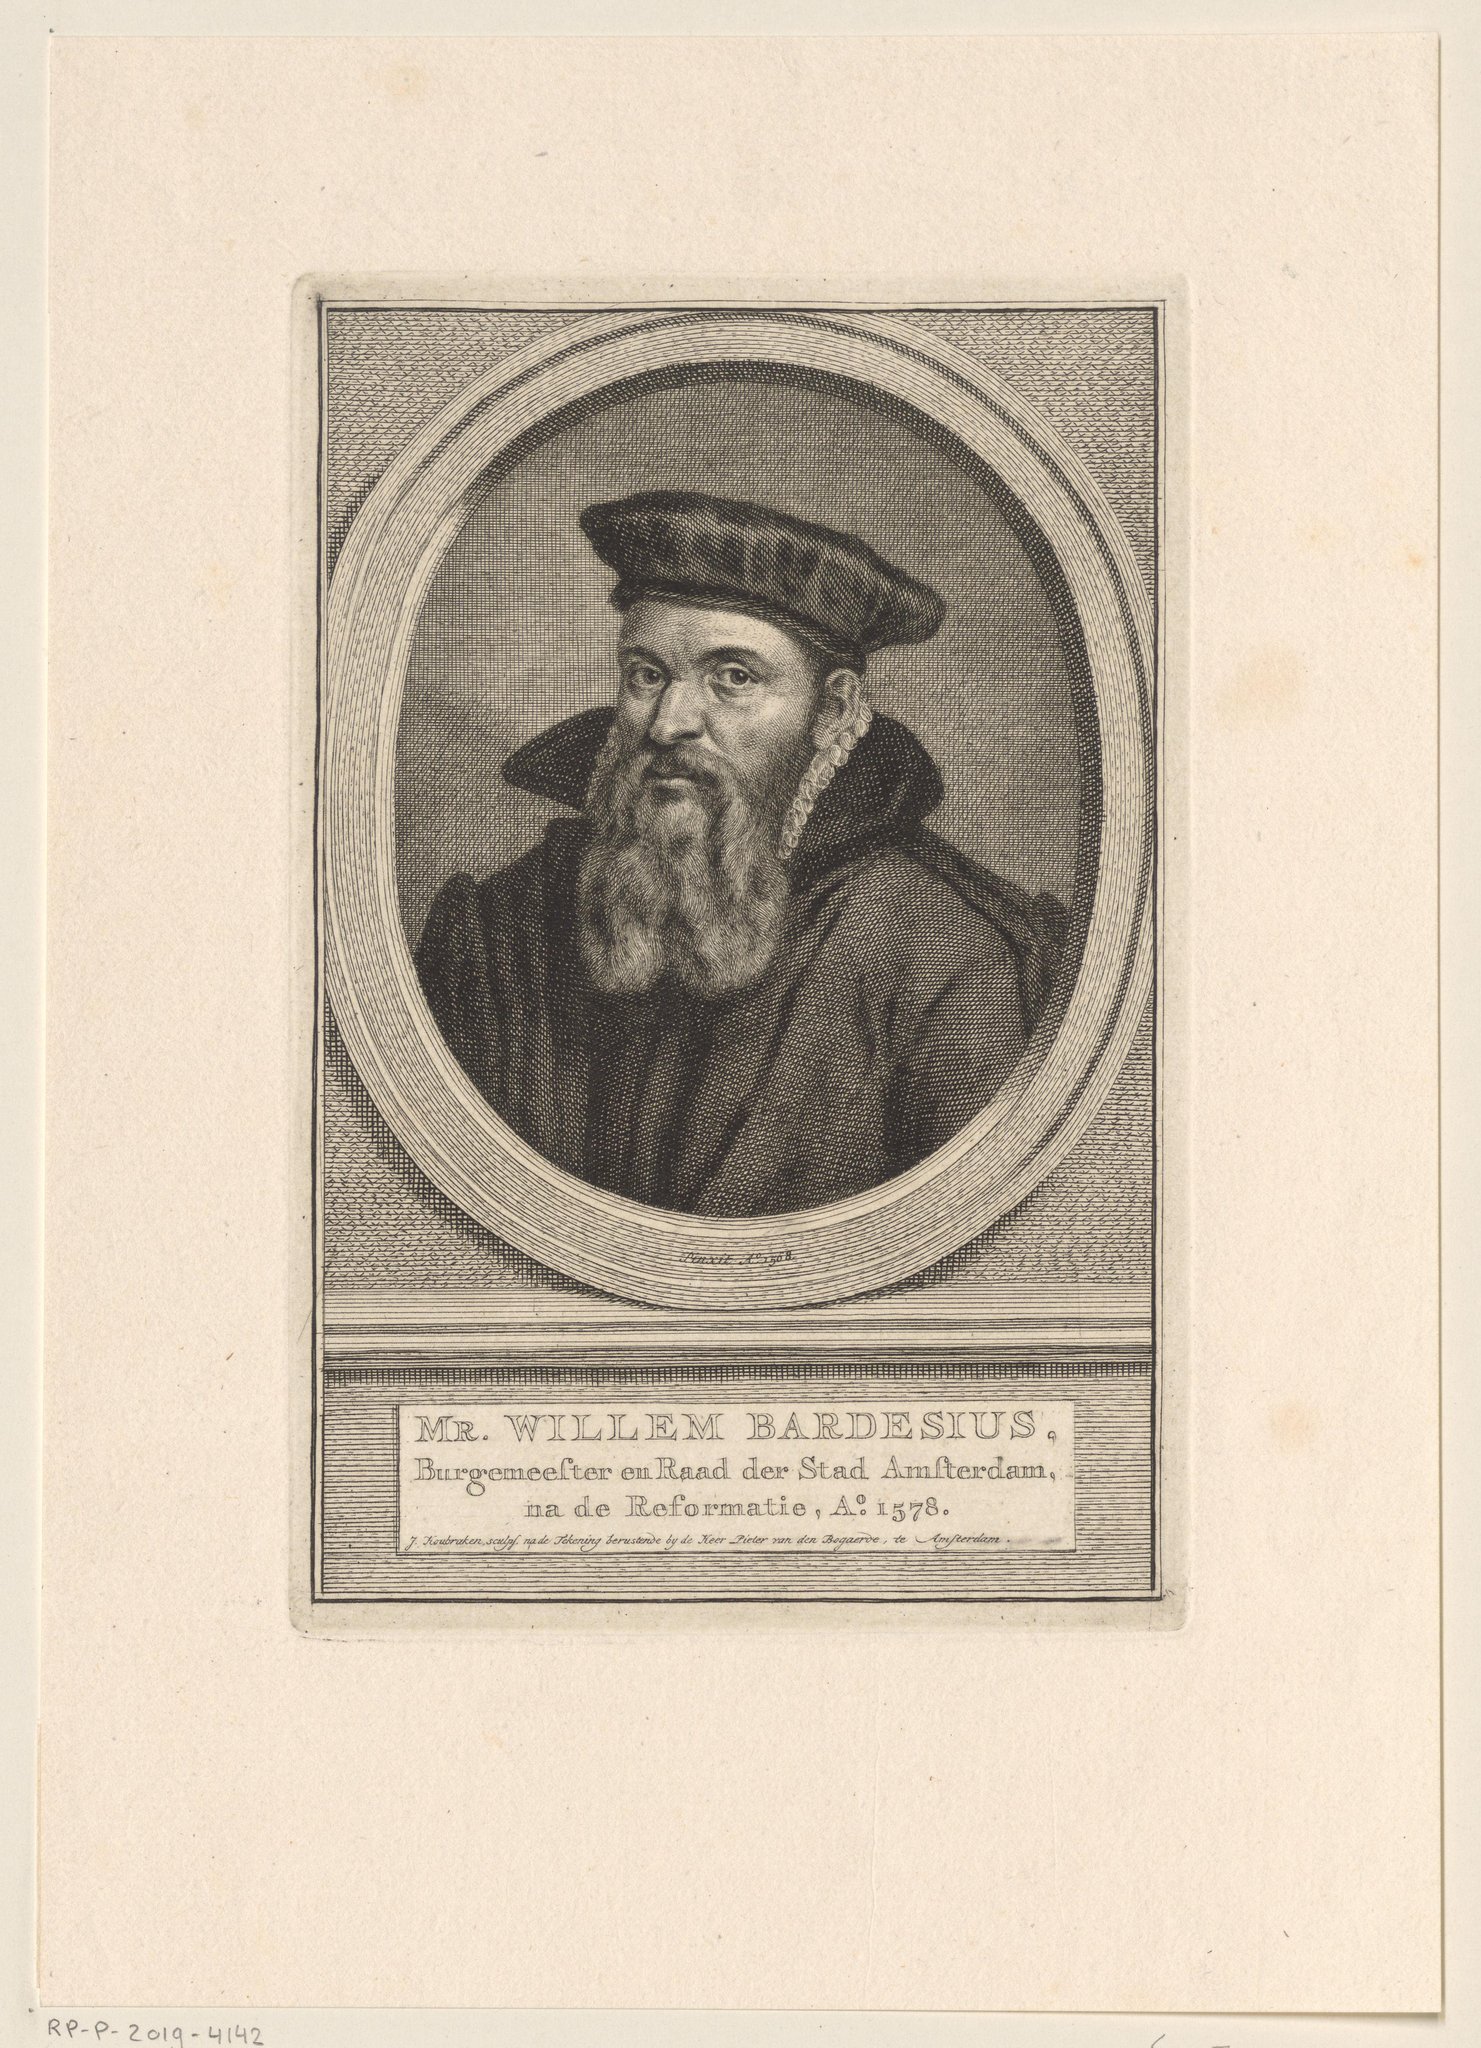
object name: print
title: Portret van Willem Bardes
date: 1749-1759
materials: paper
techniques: engraving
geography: amsterdam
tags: mayor, historical persons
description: Prent bedoeld als aanvulling op: Wagenaar, Jan. Vaderlandsche historie, vervattende de geschiedenissen der nu Vereenigde Nederlanden, inzonderheid die van Holland (...), 21 delen. Amsterdam: Isaak Tirion, 1749-1759. Prent uitgegeven in 1796 door Johannes Allart te Amsterdam.